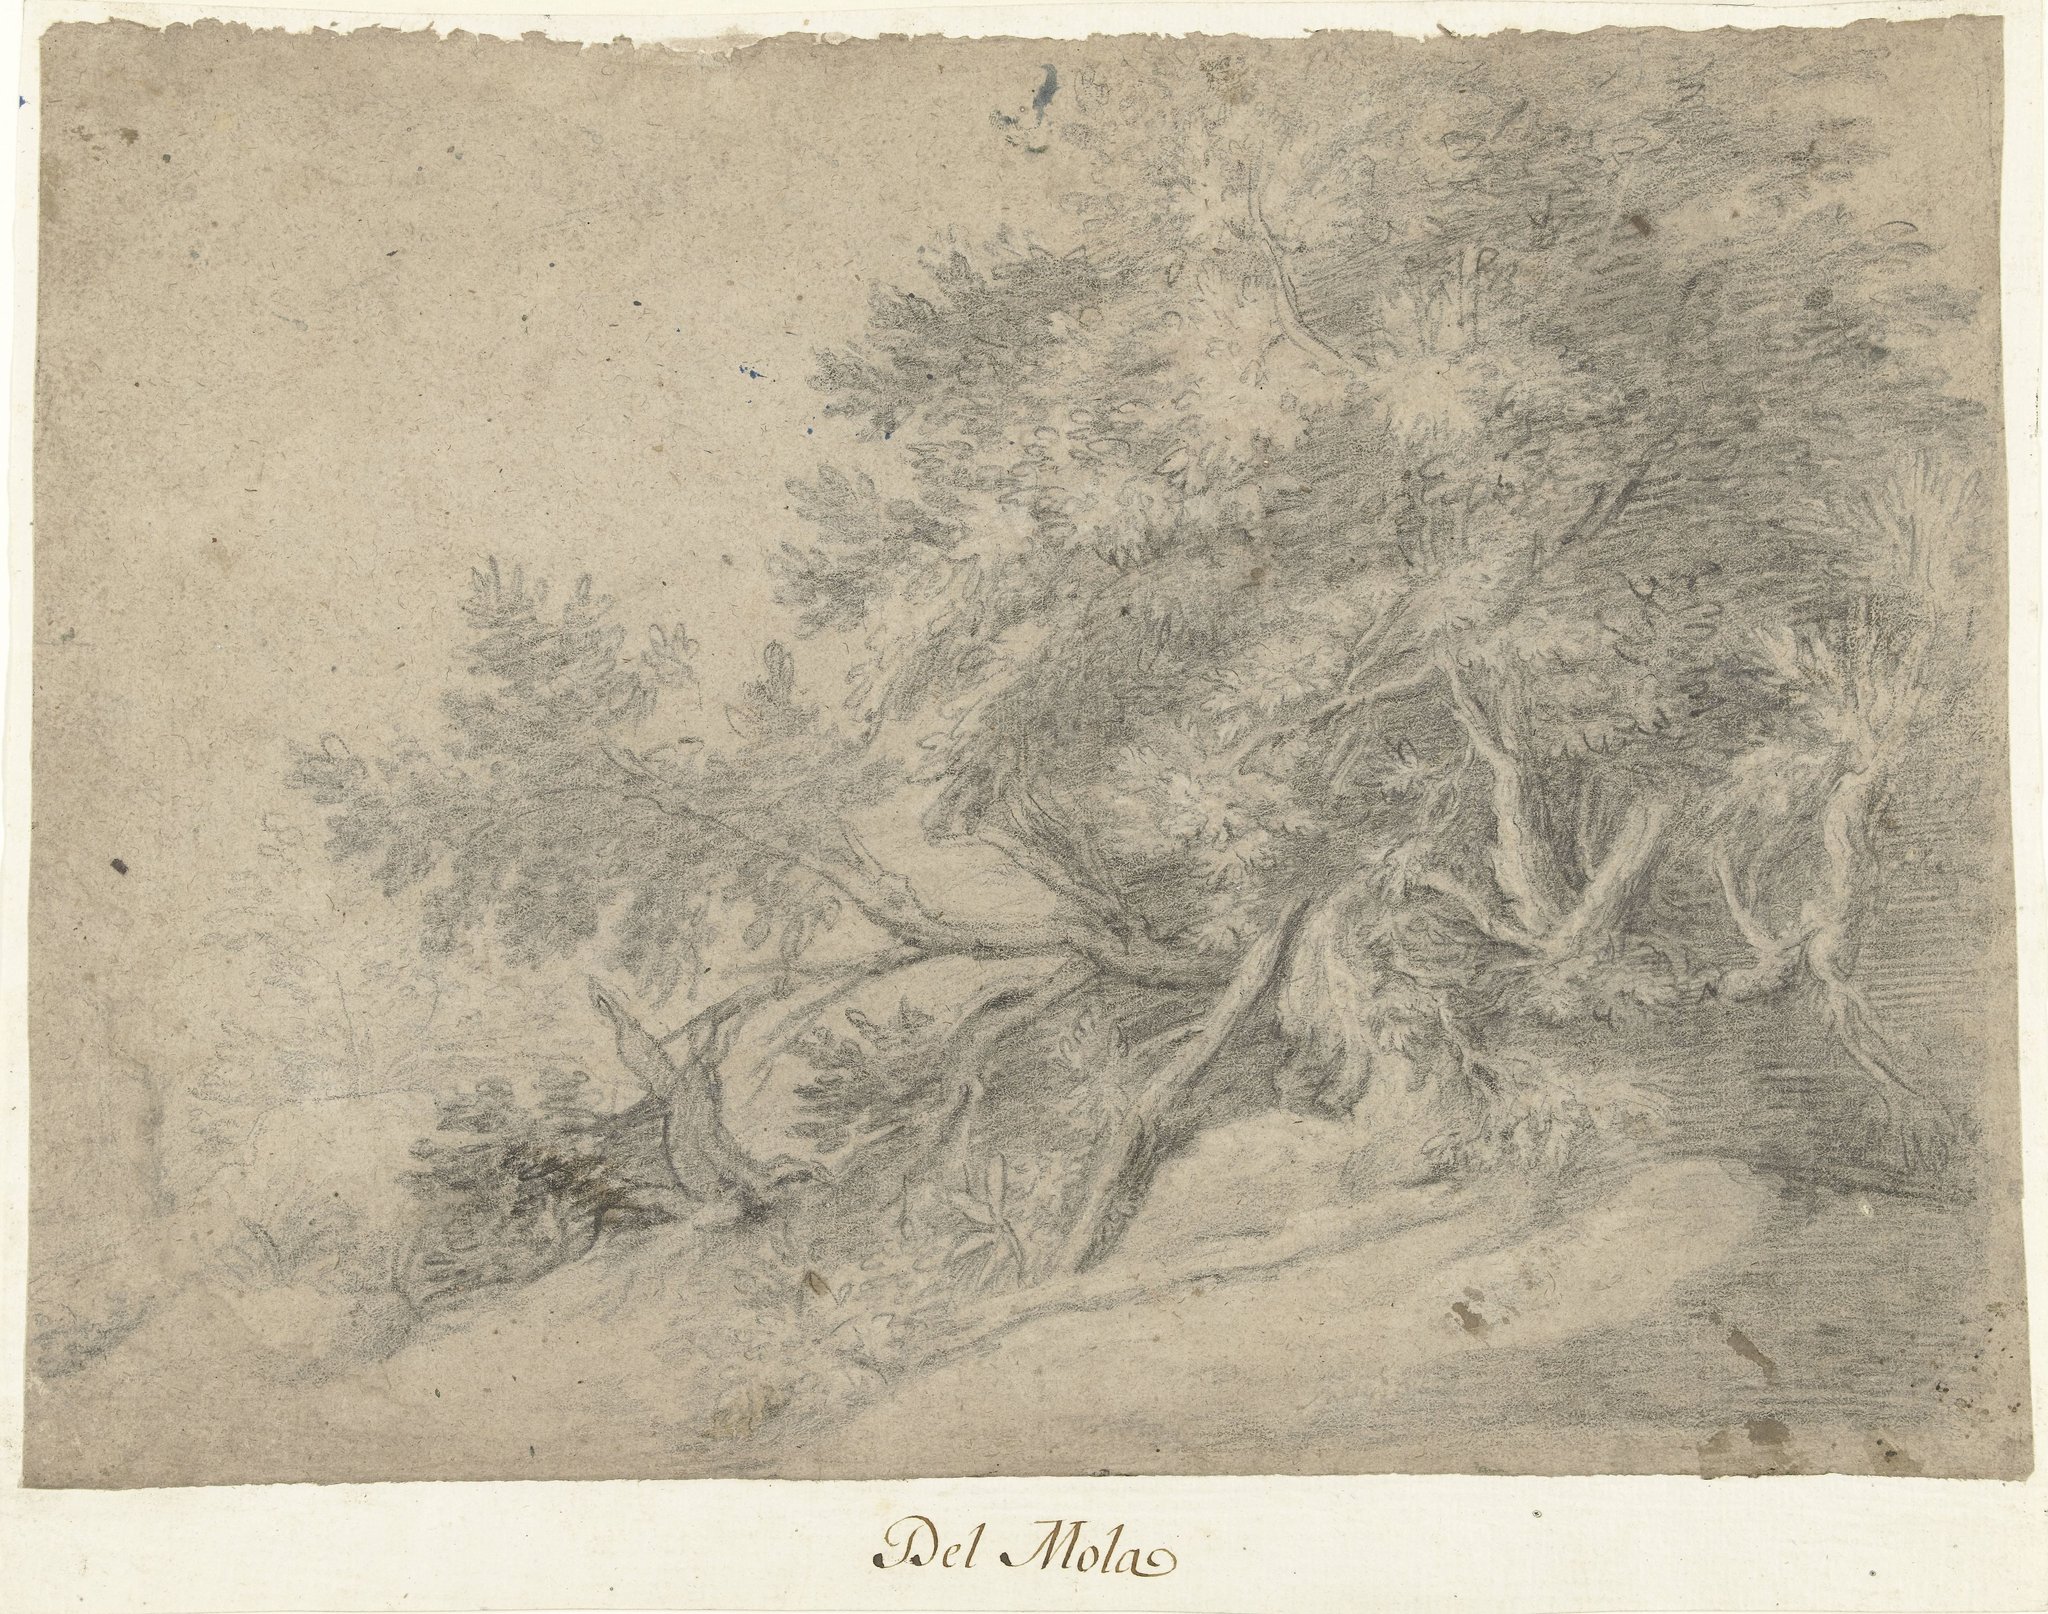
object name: drawing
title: Boomgroep in een bergachtig landschap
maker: pier francesco mola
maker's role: draughtsman, print maker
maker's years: 1612-1666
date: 1622-1666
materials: chalk, paper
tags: (high) hill, groups of trees